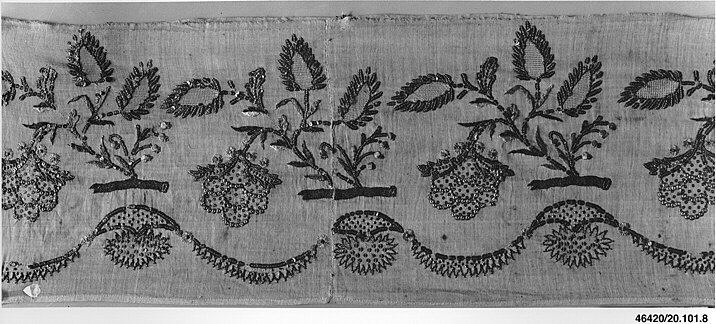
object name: strip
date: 1767-1800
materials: linen, metal thread, silk